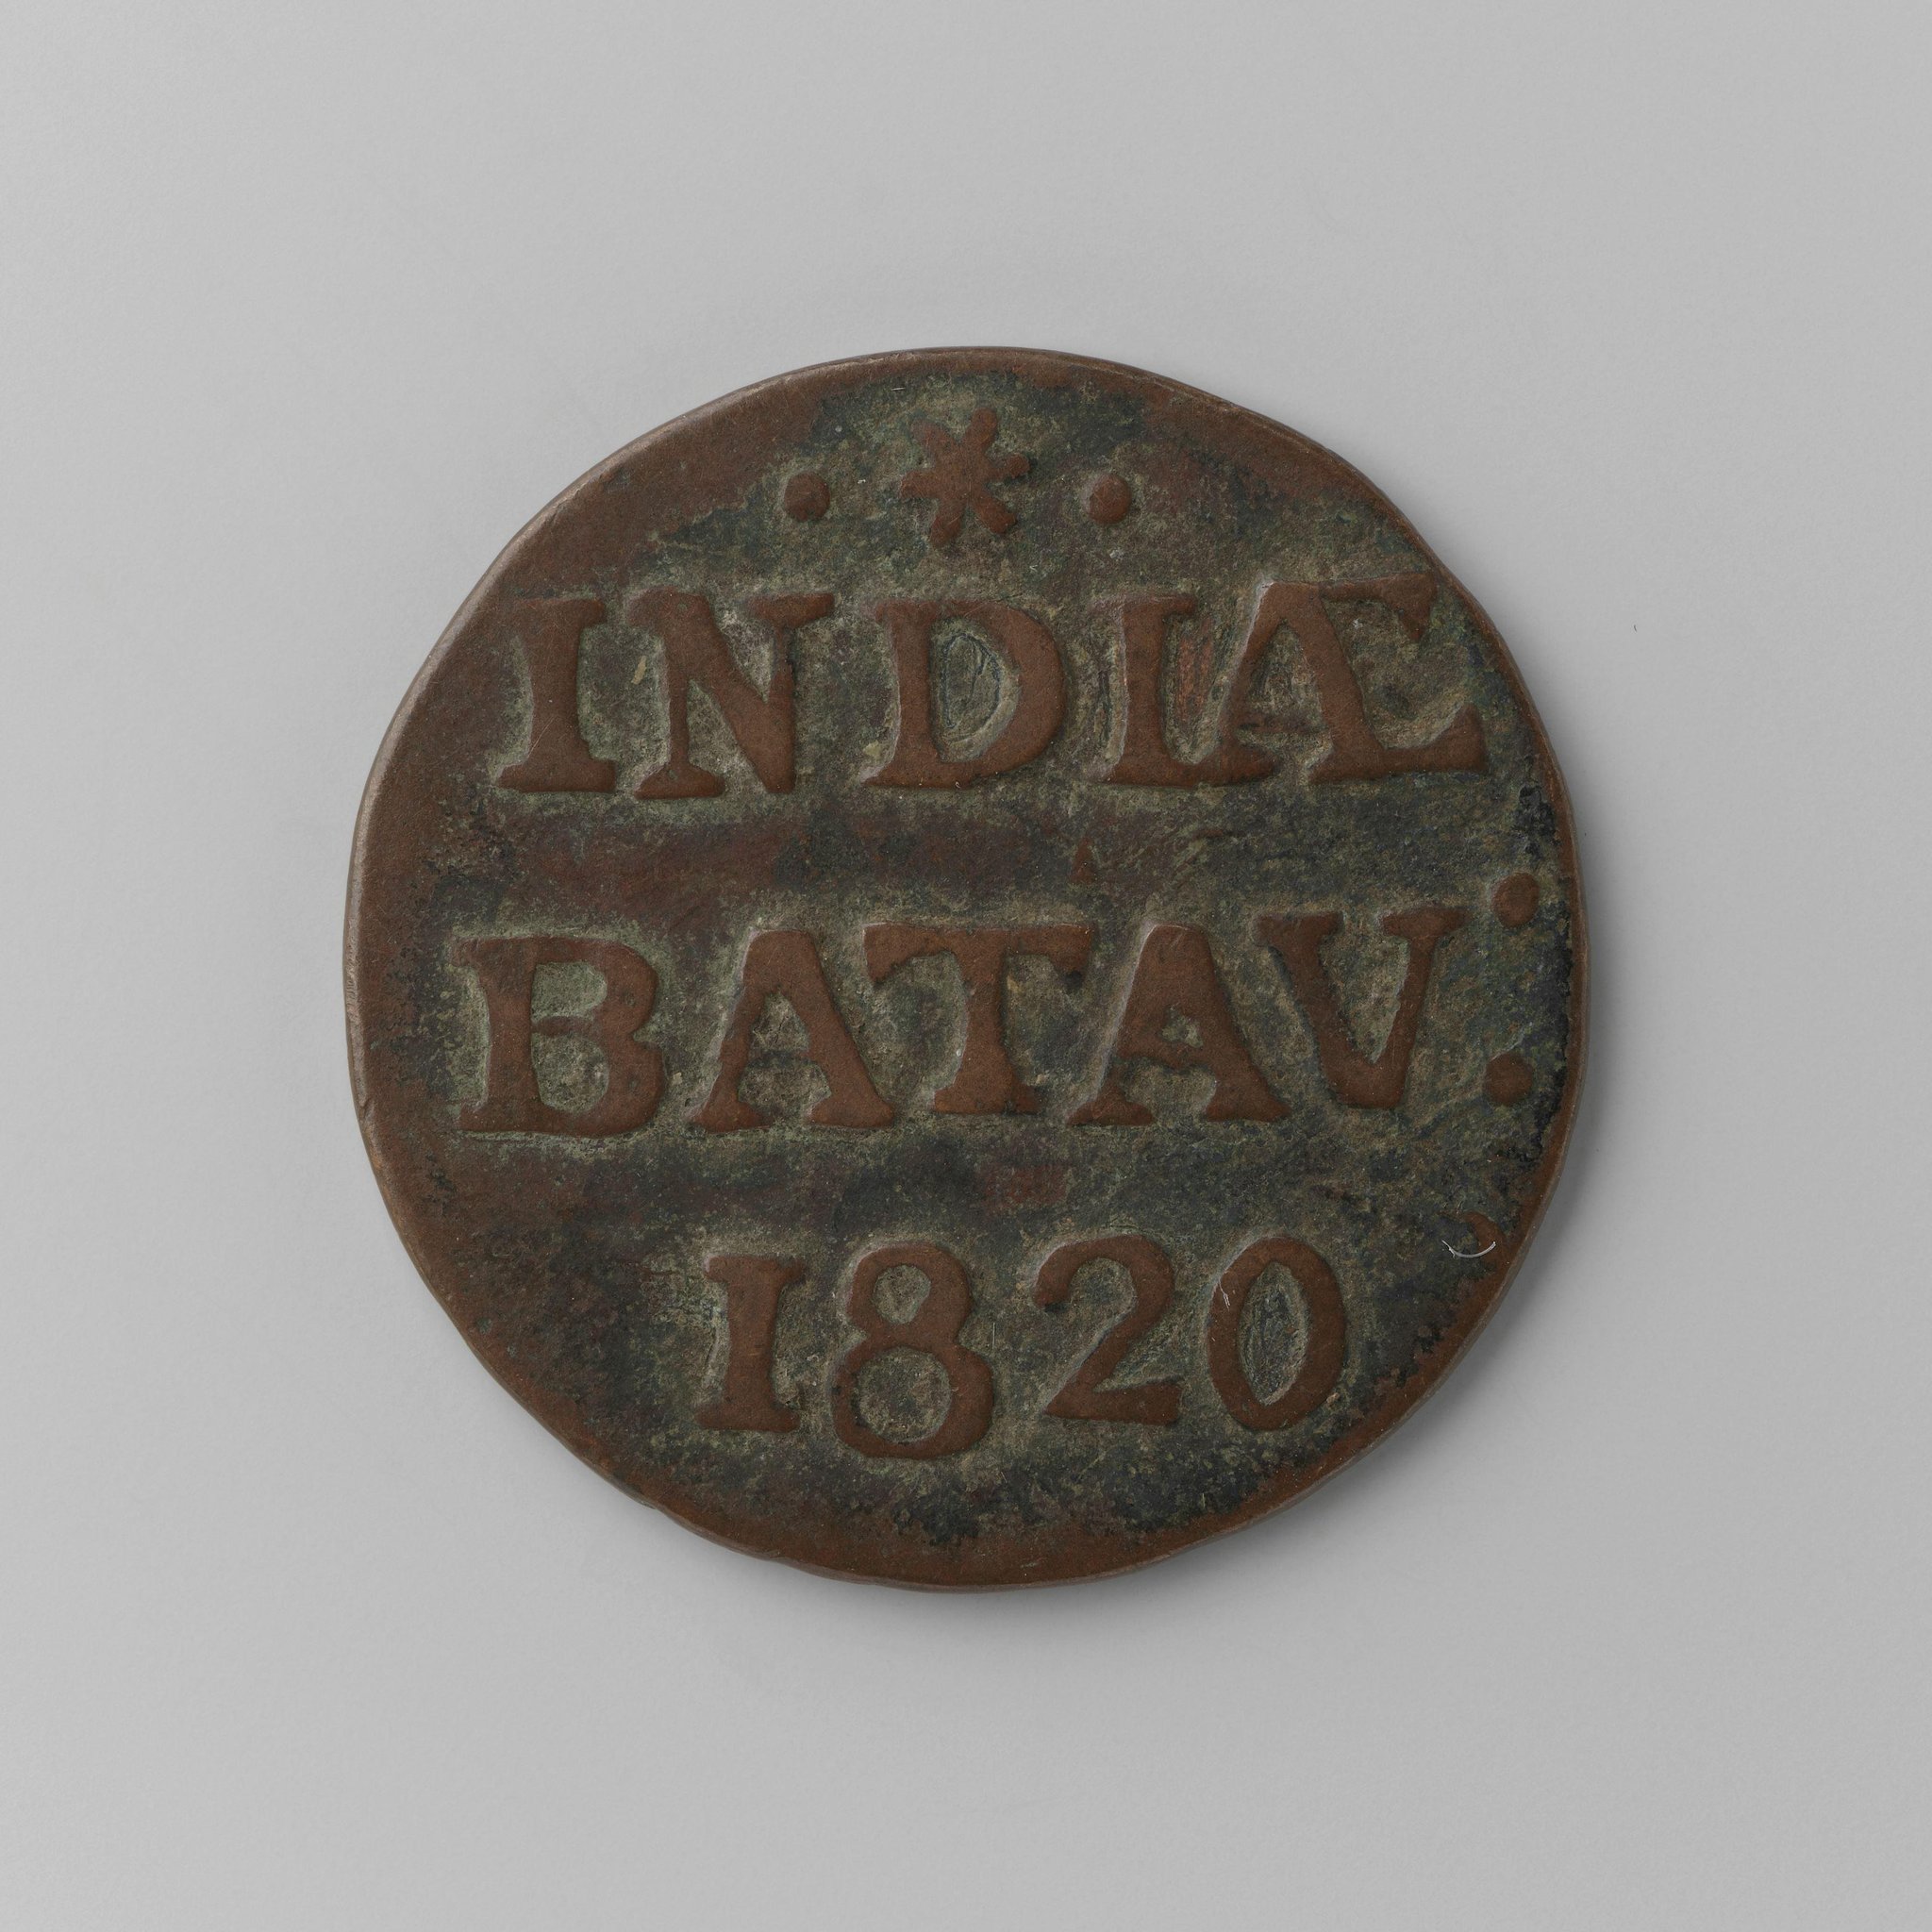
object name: coin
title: Nederlands Indië, duit,1820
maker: william i of the netherlands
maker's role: koning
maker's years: 1772-1843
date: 1820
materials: copper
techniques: striking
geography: surabaya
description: Koperen munt. Voorzijde: tussen waarde-aanduiding 5 1/16 G. gekroond generaliteitswapenschild. Keerzijde: tweeregelig opschrift, waarboven muntteken en waaronder jaartal. Gladde rand.